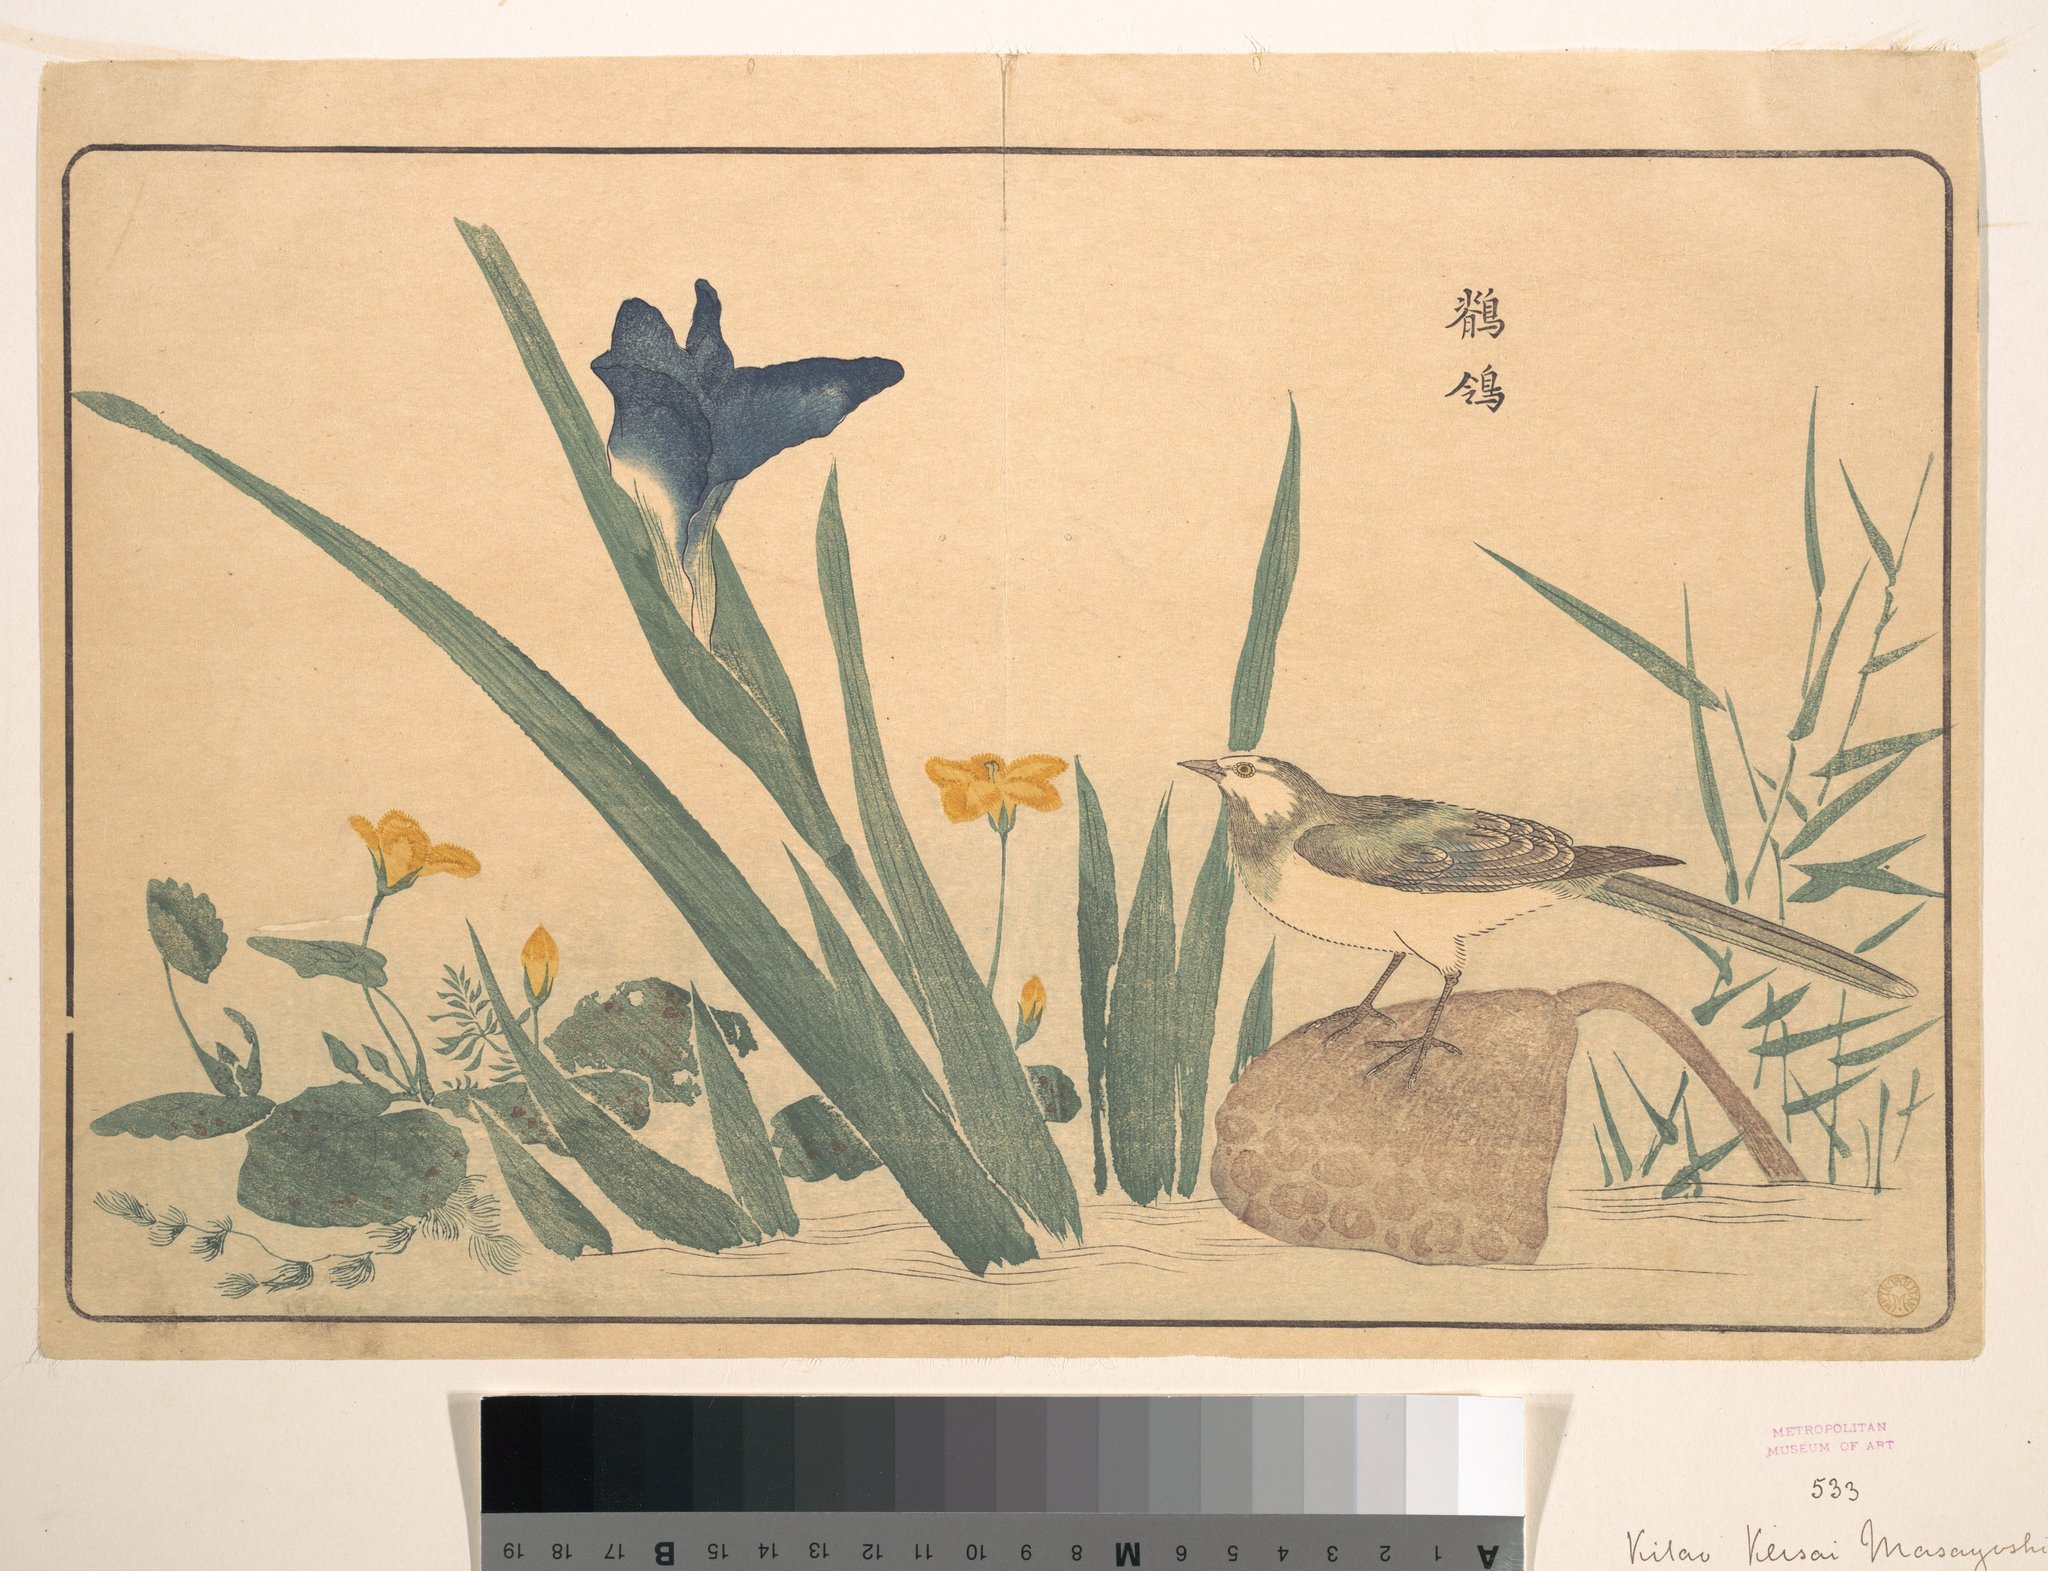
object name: print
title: The Pied Wagtail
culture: japanese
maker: kuwagata keisai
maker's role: artist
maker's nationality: japanese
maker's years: 1764-1824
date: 1789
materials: ink, paper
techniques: woodblock print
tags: birds,flowers,leaves